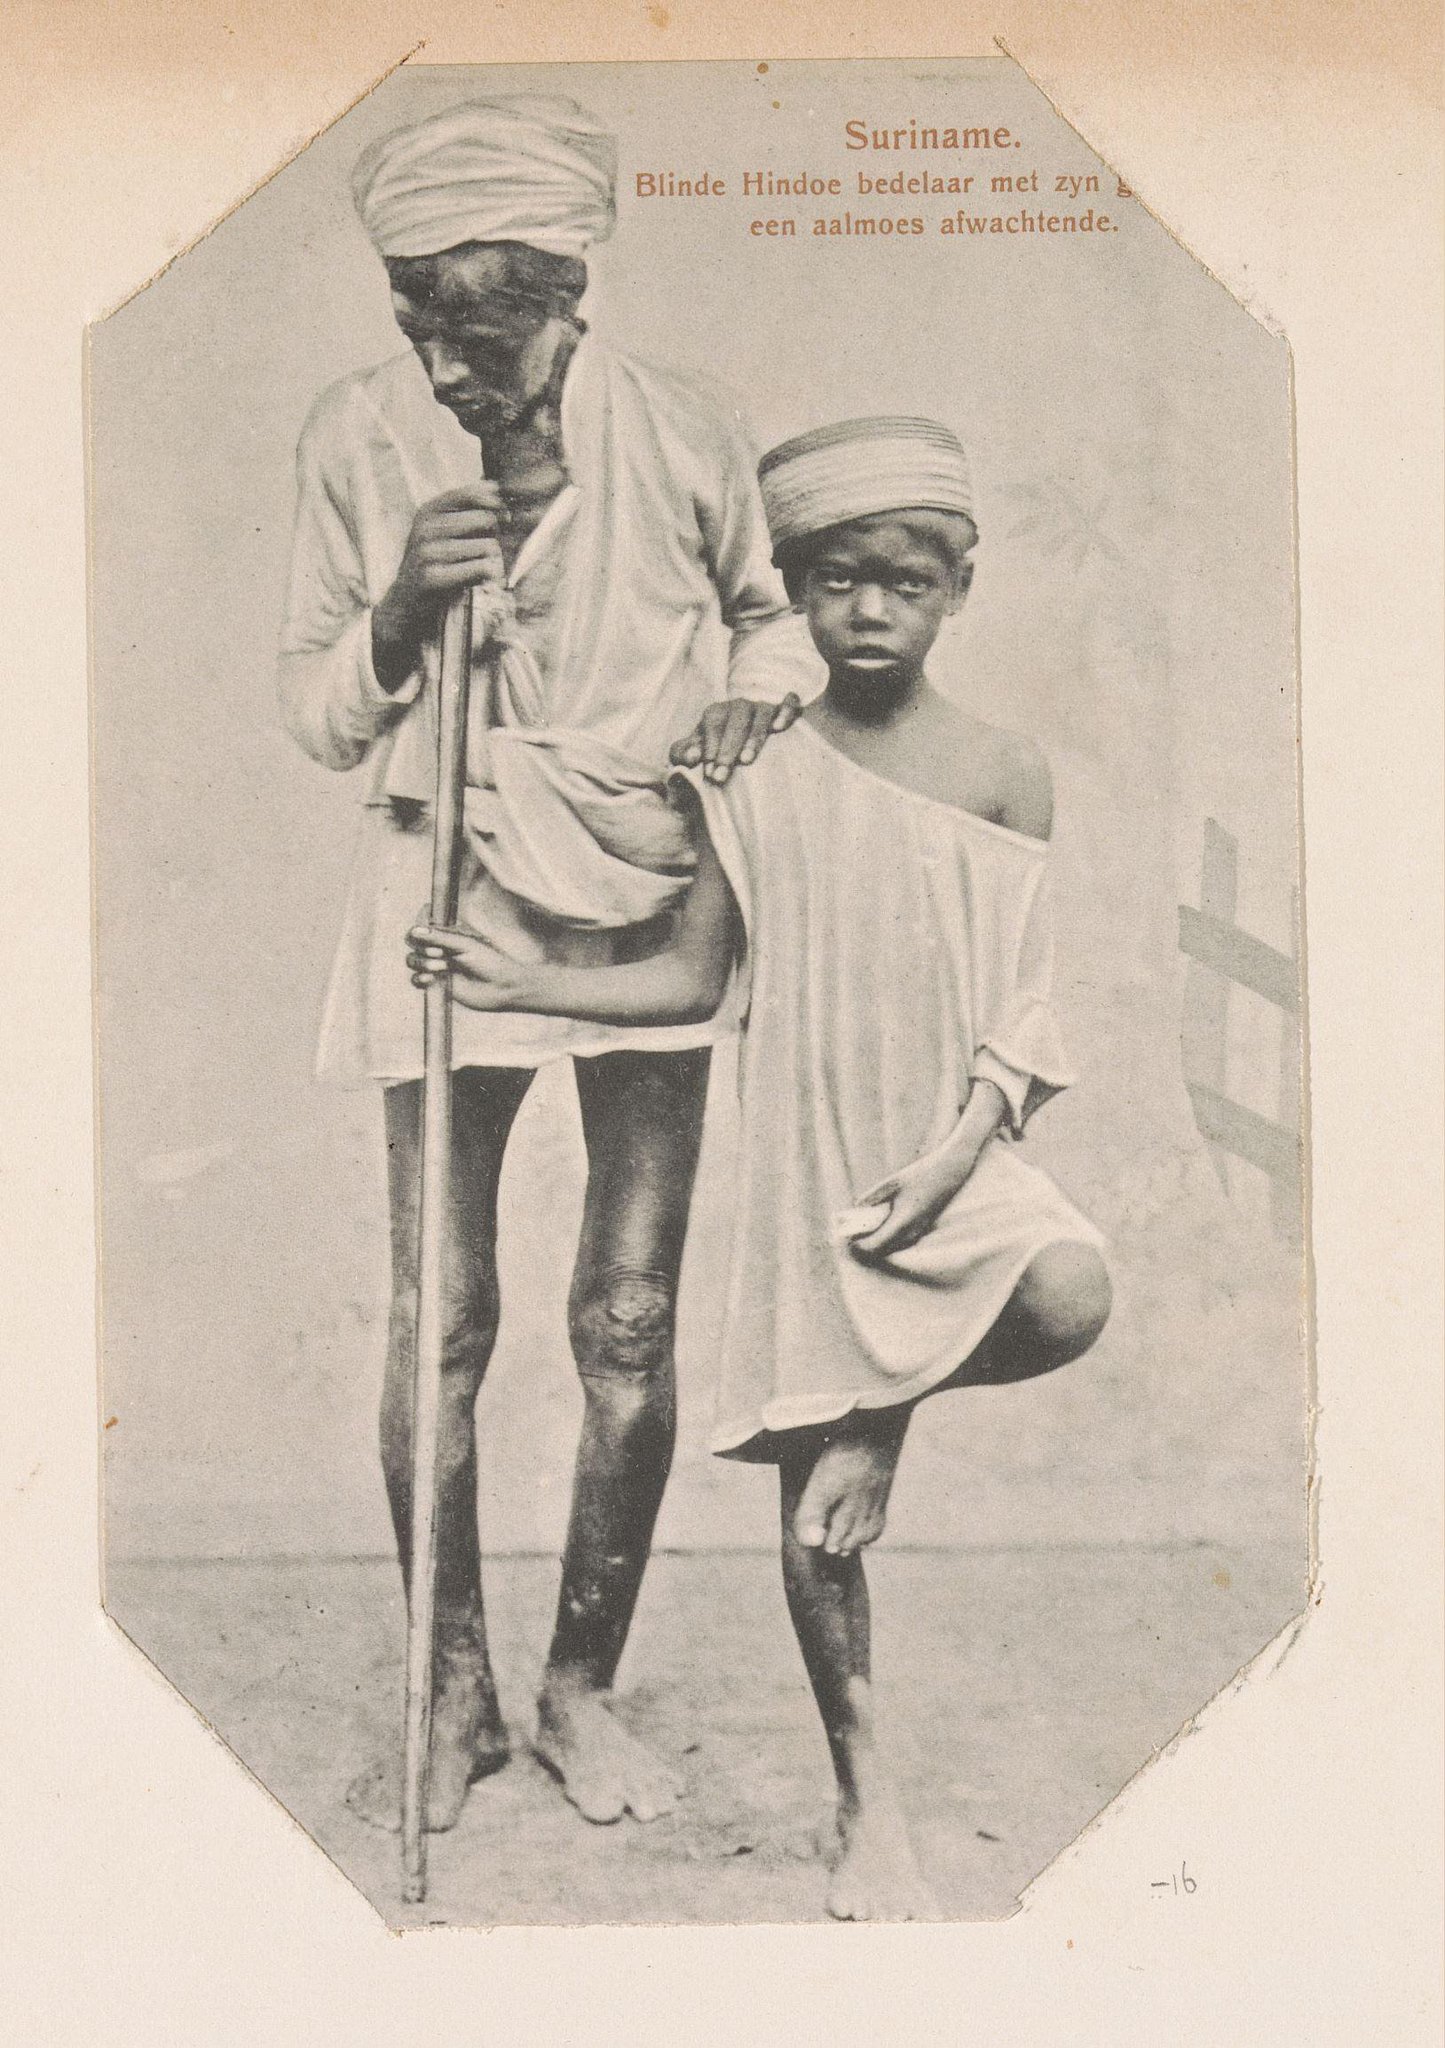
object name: ansichtkaart, prentbriefkaart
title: Suriname. Blinde Hindoe bedelaar met zyn geleider een aalmoes afwachtende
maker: eugen klein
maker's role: fotograaf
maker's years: 1869-1927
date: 1900-1910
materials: cardboard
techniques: photograph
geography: paramaribo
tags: hinduism, buddhism, jainism, blind, blindness, beggar, suriname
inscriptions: serial number: ‘Eigendom van Eugen Klein, Paramaribo No. 38’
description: Een blinde hindoe bedelaar samen met zijn begeleider, een jonge jongen. Onderdeel van een verzameling van 68 briefkaarten uit Suriname, bijeengebracht in een album als aandenken aan een verblijf in Suriname in september 1911.